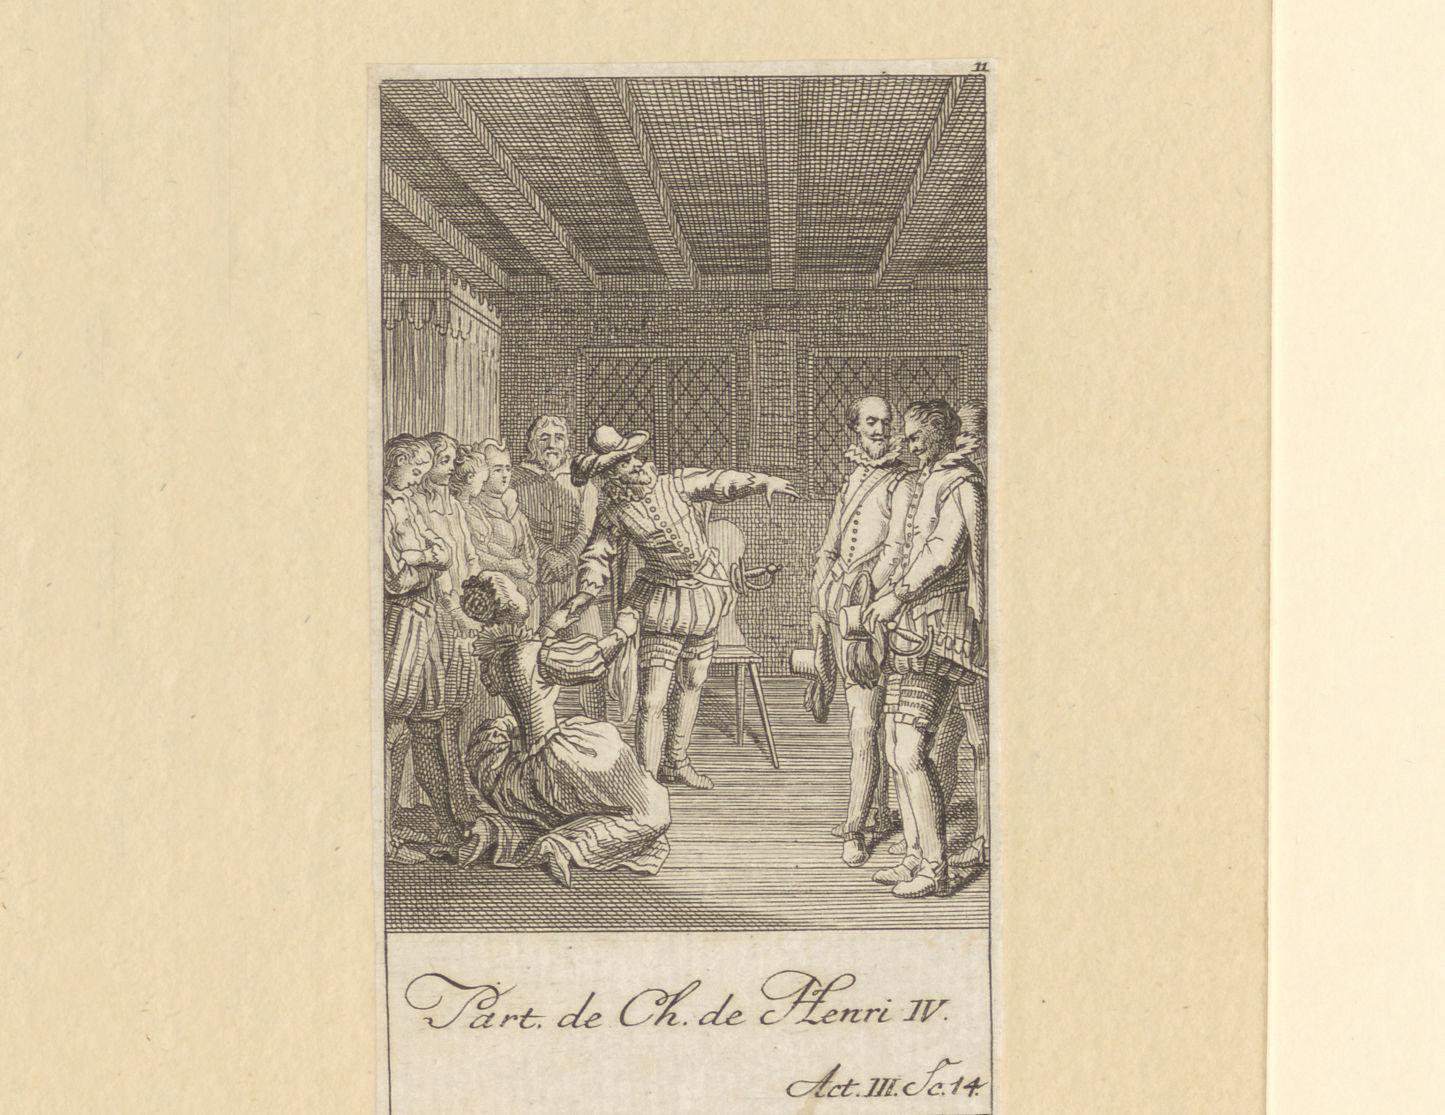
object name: book illustration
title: Agathe op haar knieën voor Hendrik IV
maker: daniel berger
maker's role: print maker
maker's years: 1744-1824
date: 1774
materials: paper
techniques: etching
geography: berlin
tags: paris, hendrik iv (koning van frankrijk en navarra), literary characters and objects, kneeling on both knees - aa - female human figure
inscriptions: collector's mark: Lugt 2228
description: Prent afkomstig uit: Almanac généalogique: pour l'année 1785, uitgegeven te Berlijn. Deze prent maakt deel uit van een serie van twaalf prenten, gedrukt van een koperplaat. De prenten tonen scènes uit het toneelstuk 'La partie de chasse de Henri IV' (1767) van Charles Collé. Deze serie verscheen eerder met Duitse onderschriften in: Genealogischen Calender für West-Preussen auf das Jahr 1775, uitgegeven op kosten van de Konigliche Academie der Wissenschaften.